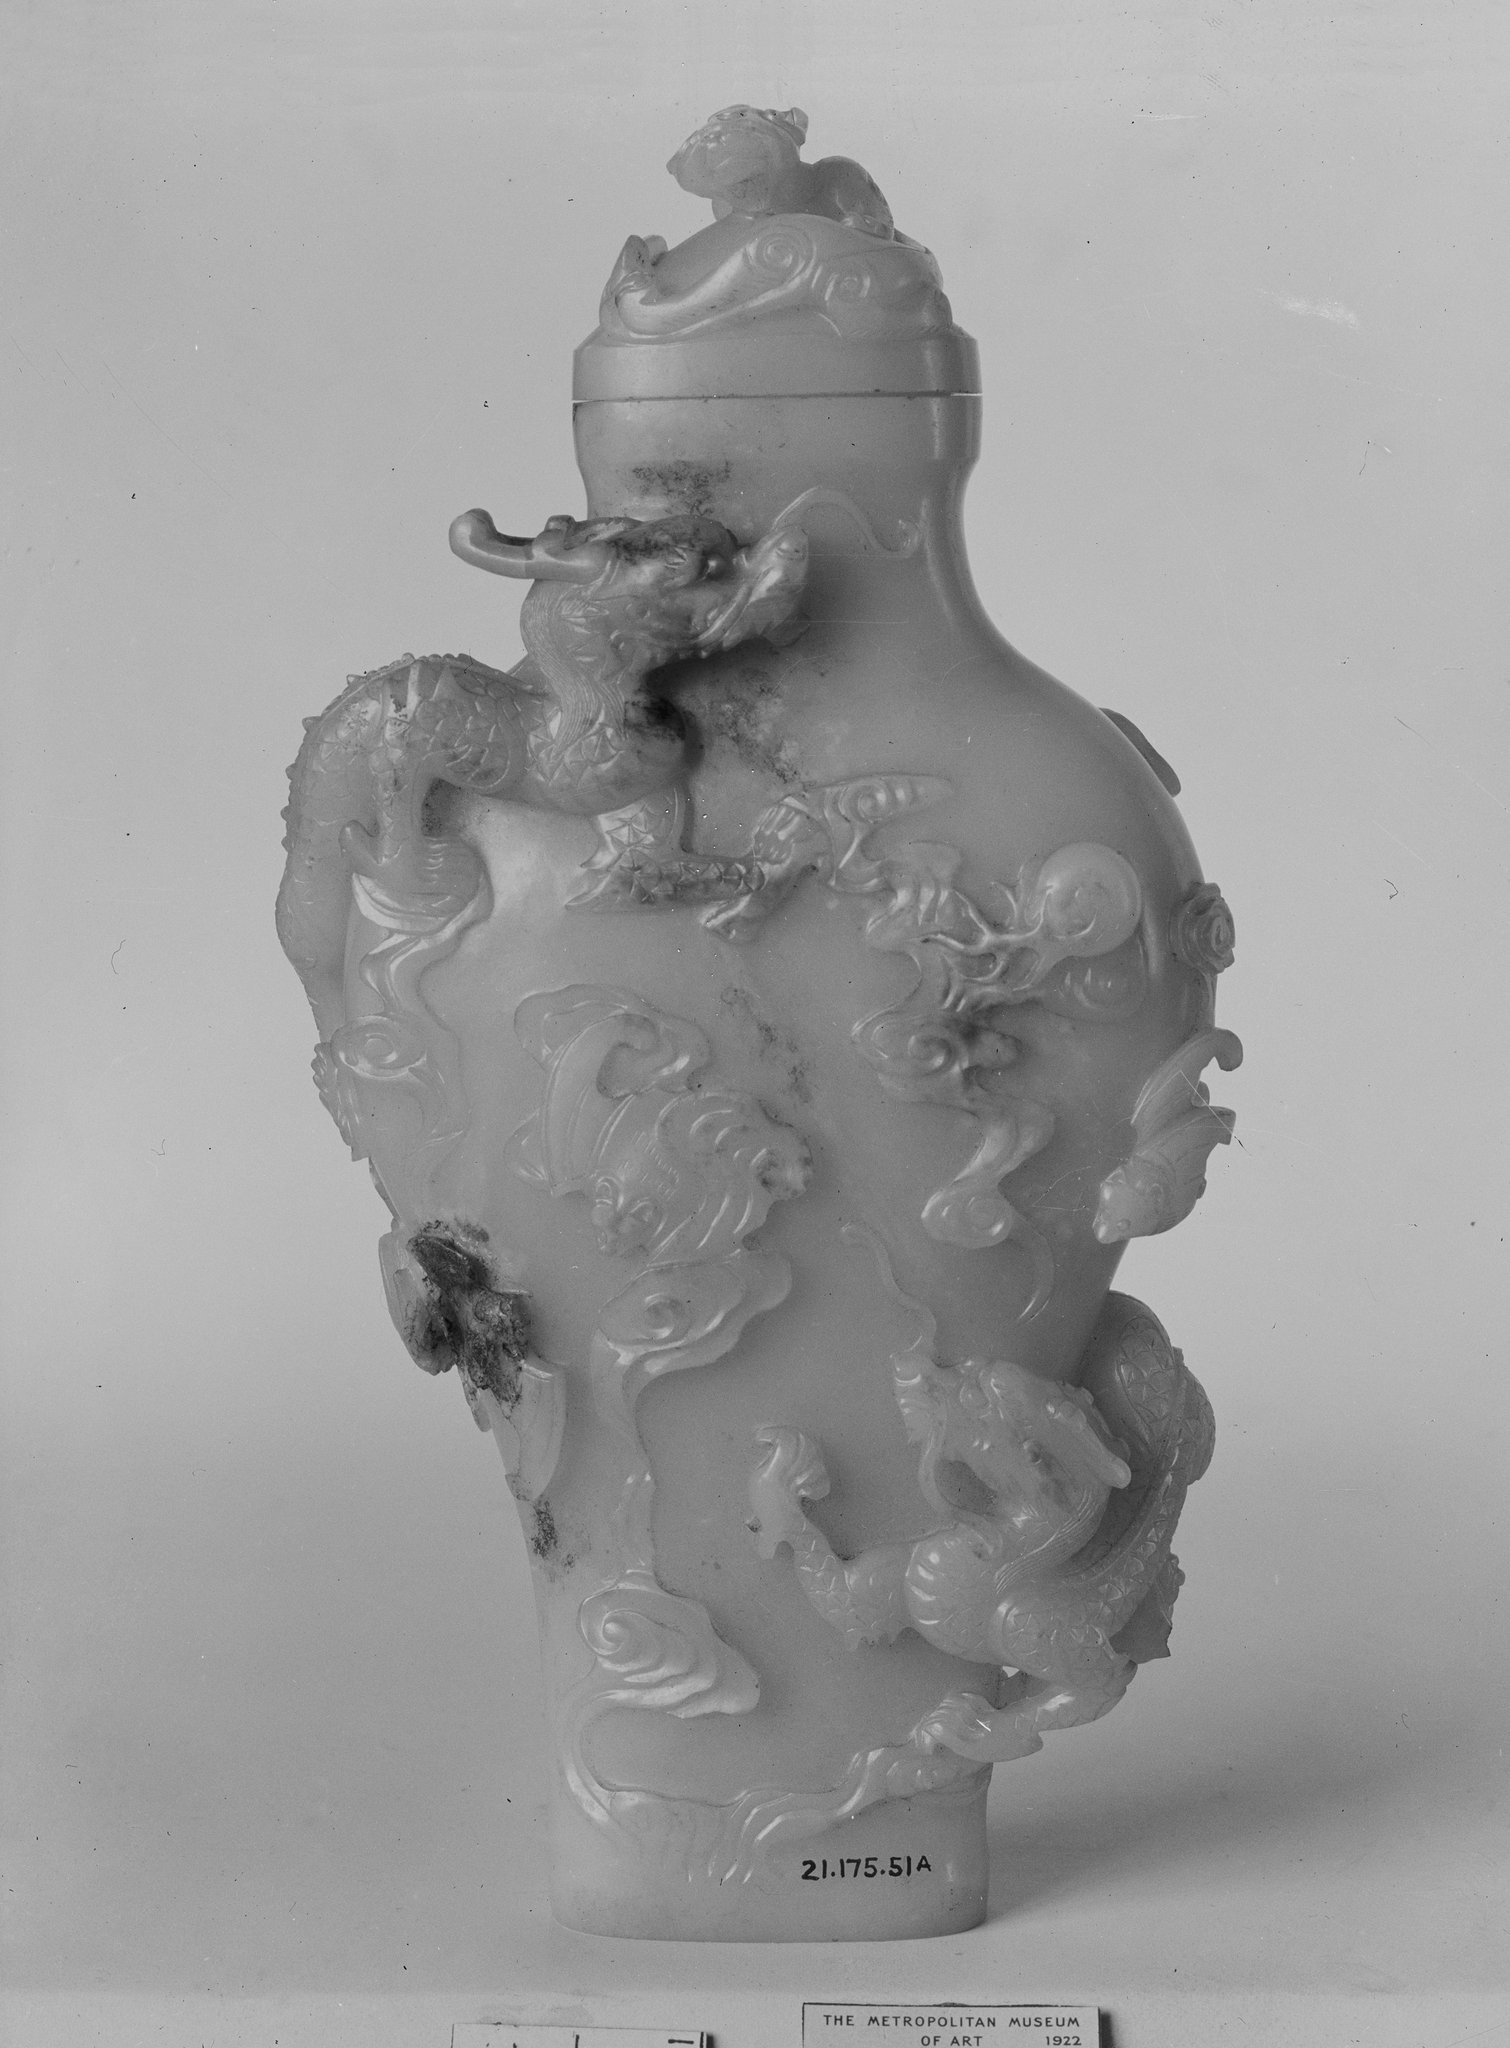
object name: vase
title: Dragon Vase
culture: chinese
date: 1736-1795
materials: jade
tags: dragons